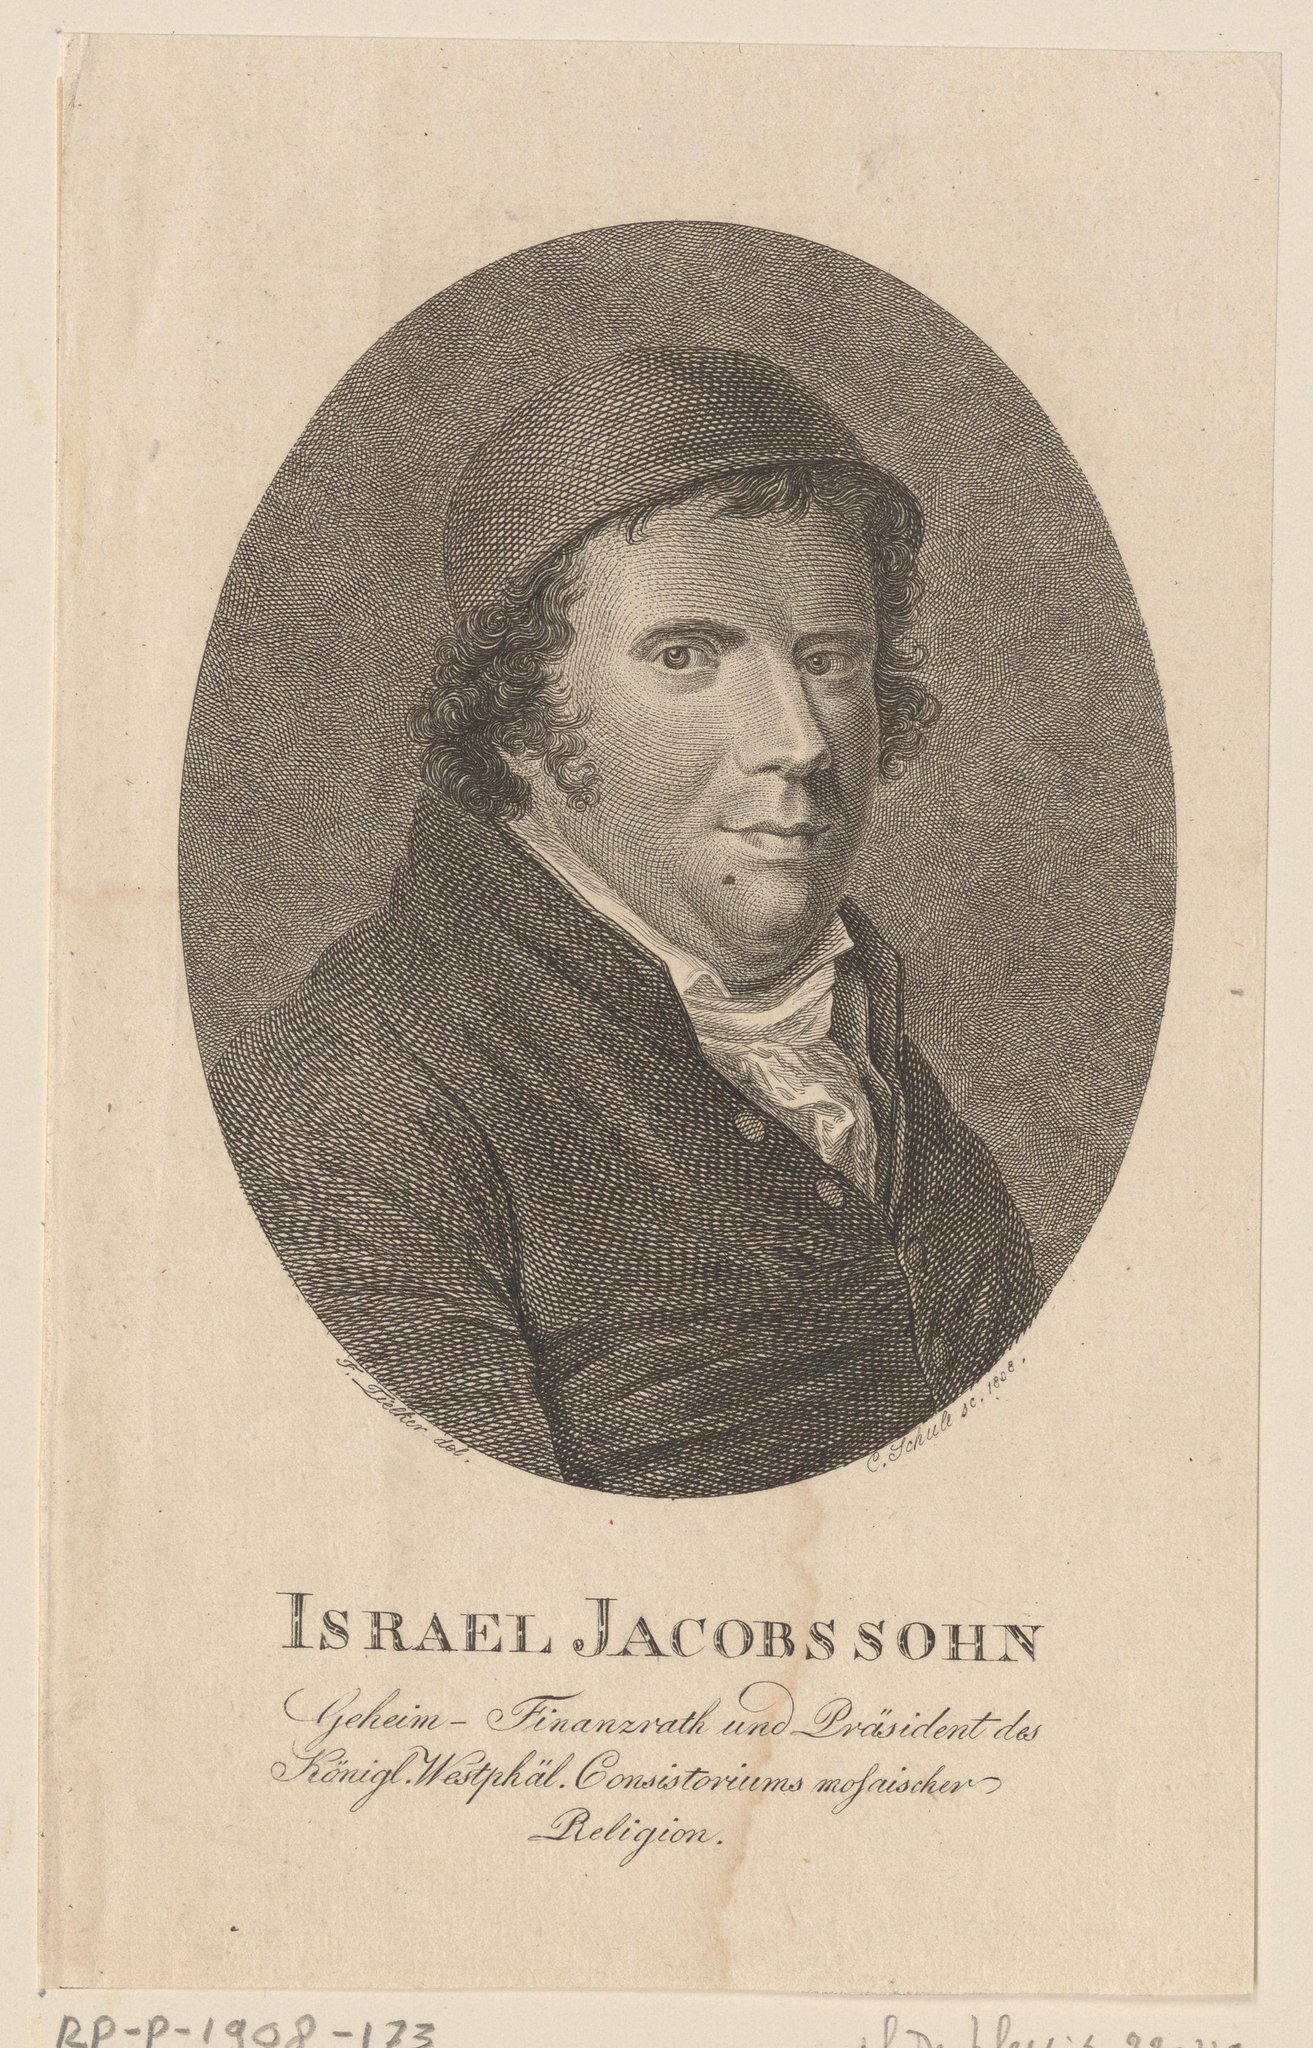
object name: print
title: Portret van Israel Jacobssohn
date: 1808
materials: paper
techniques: etching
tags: philantropist, historical persons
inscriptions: collector's mark: Lugt 2228